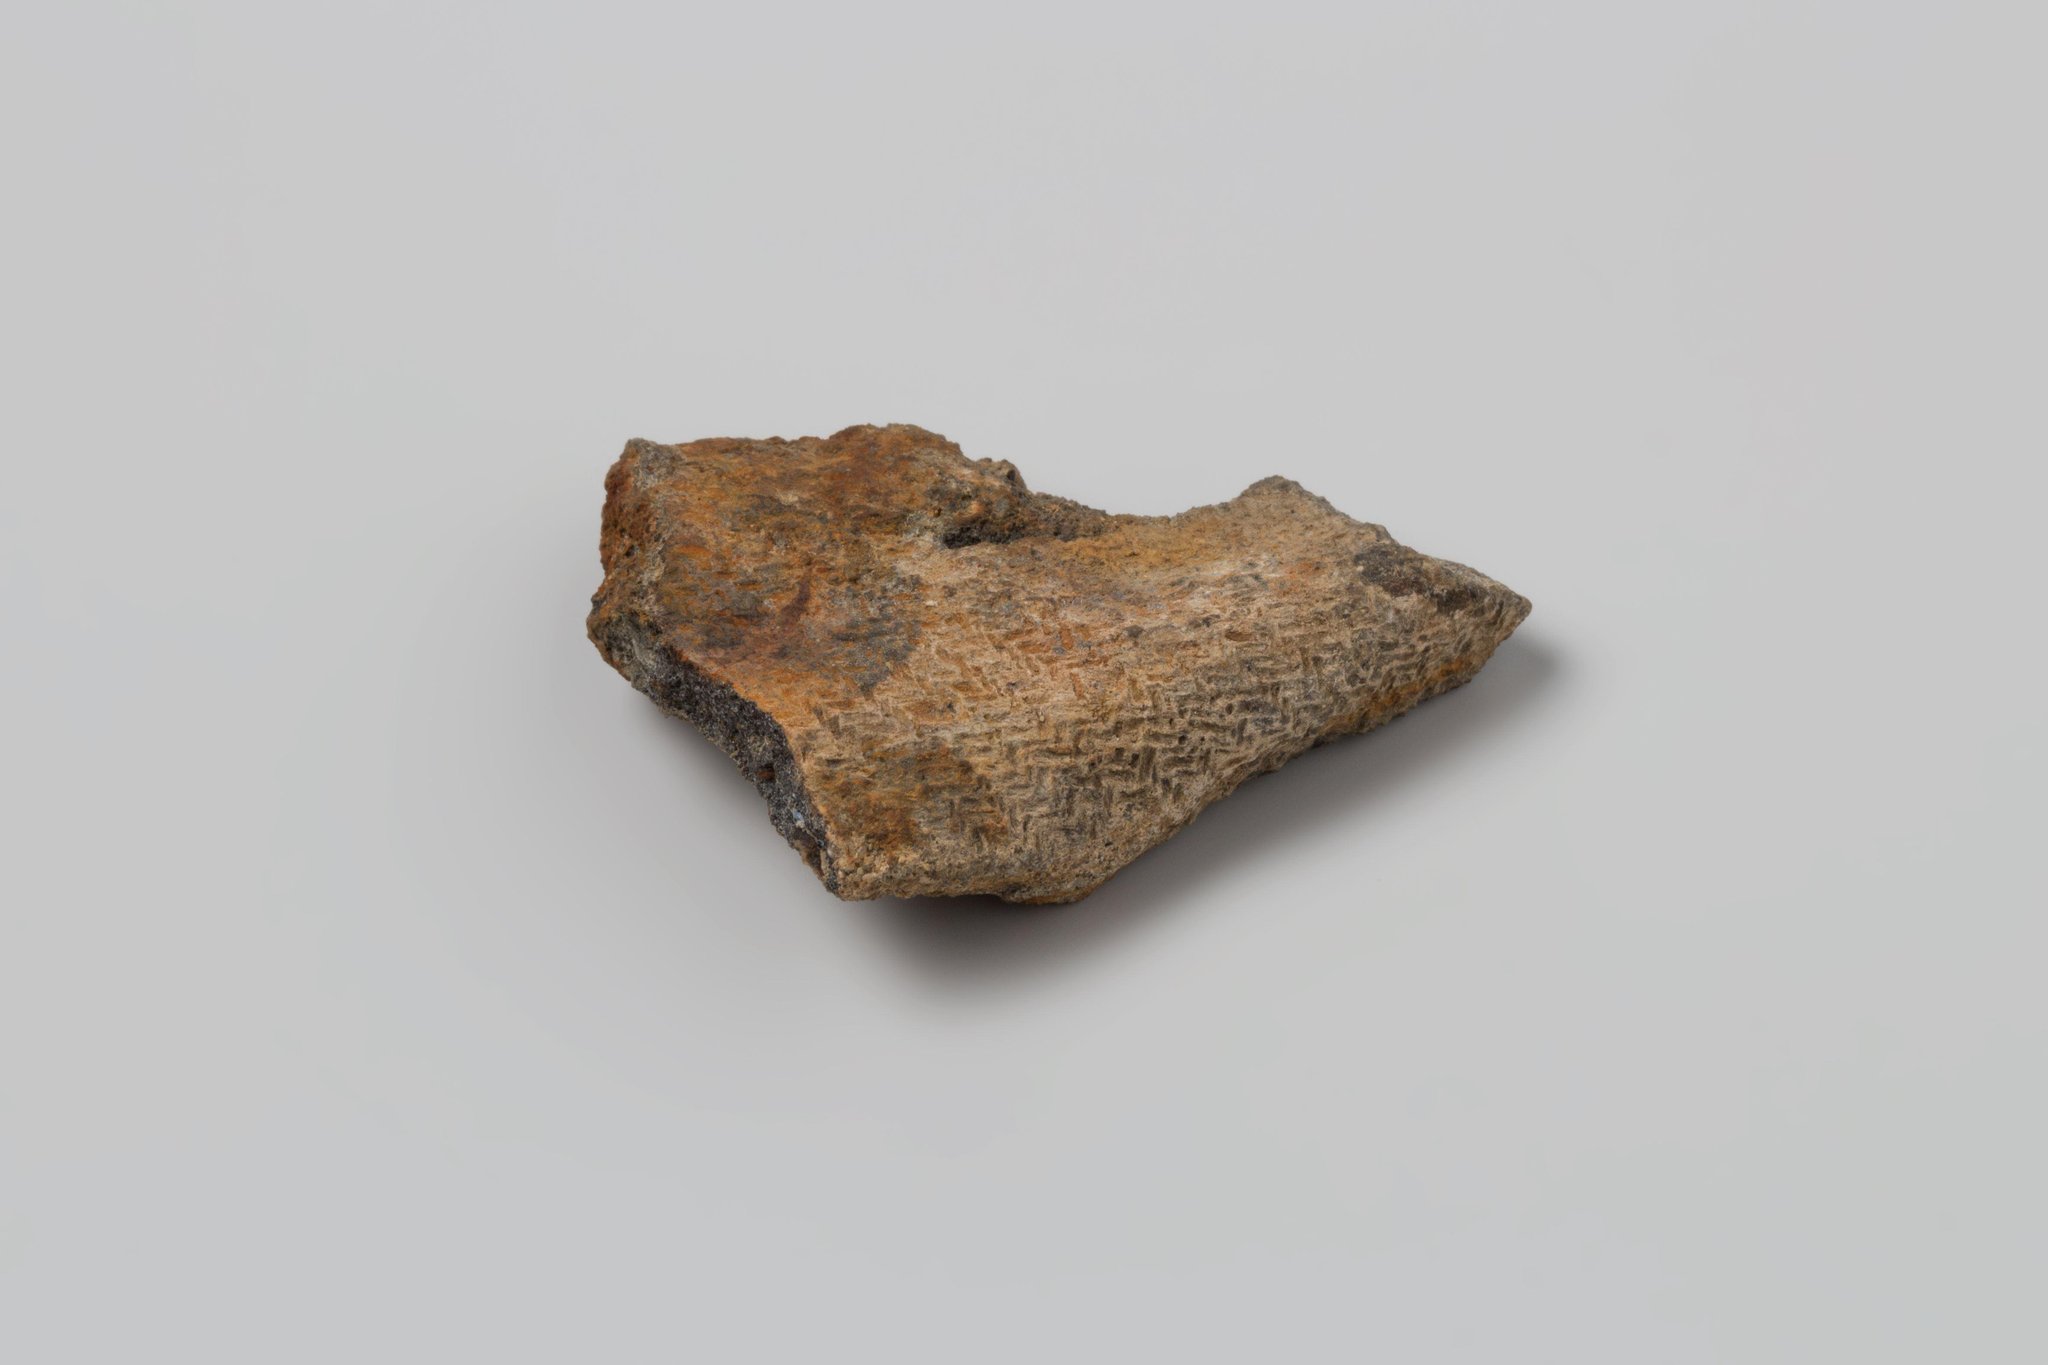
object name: concretionary stone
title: Metaalfragment (ijzer?) met afdruk aan het oppervlak van een textielstructuur, afkomstig uit het wrak van de in 1735 vergane Oost-Indiëvaarder 't Vliegend Hart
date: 1700-1735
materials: stone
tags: 't vliegend hart (schip), verenigde oostindische compagnie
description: Het fragment heeft ooit tegen een textielen voorwerp gelegen, waarvan het patroon als afdruk duidelijk te zien is. Het patroon bestaat uit hele fijne schering en inslagdraden. Concretion.